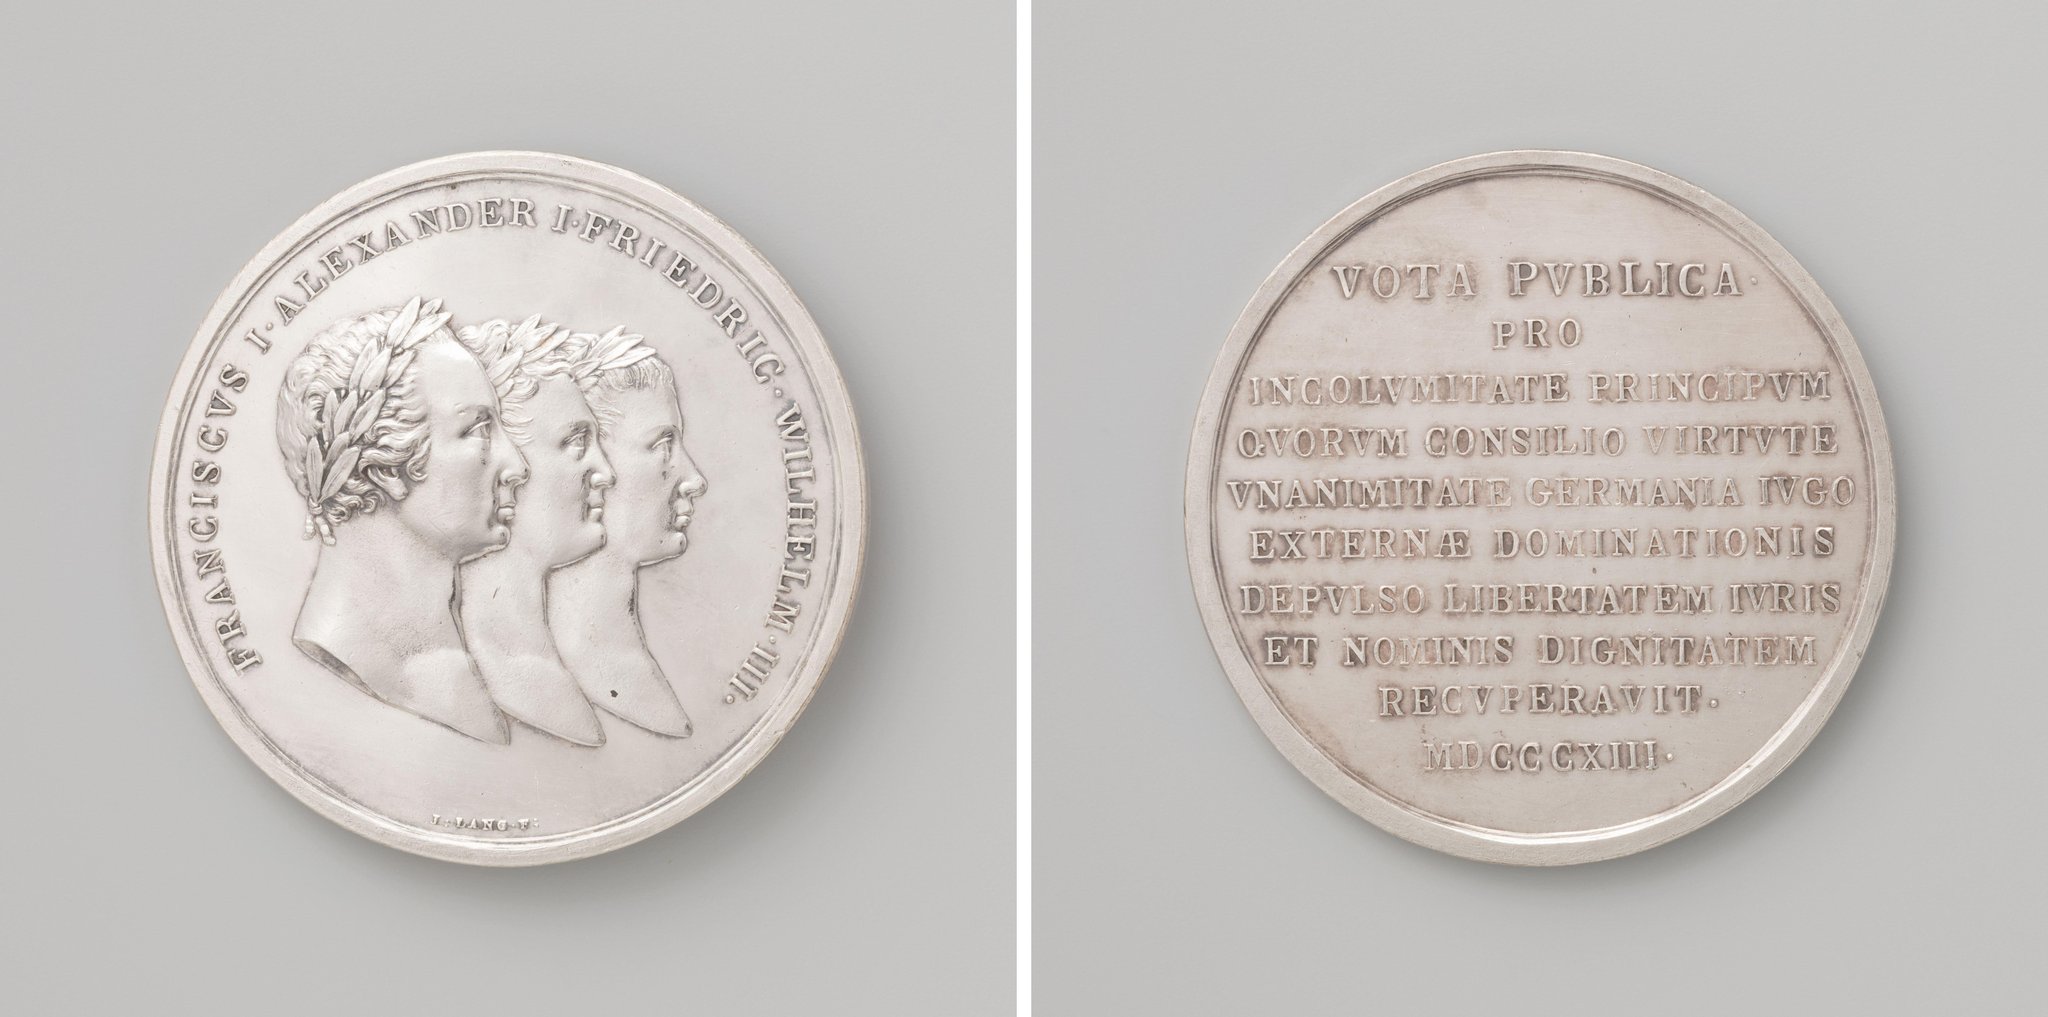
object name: history medal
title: Verdrag van Teplitz, ter ere van Alexander I, tsaar van Rusland, Frans I, keizer van Oostenrijk en Frederik Willem III, koning van Pruisen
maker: josef nikolaus lang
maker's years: 1776-1835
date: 1813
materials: silver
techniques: striking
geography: hall am inn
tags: frans ii (rooms-duits keizer), alexander i (tsaar van rusland), berlin, frederik willem iii koning van pruisen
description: Zilveren penning. Voorzijde: borststukken van drie mannen met lauwerkransen binnen omschrift. Keerzijde: opschrift